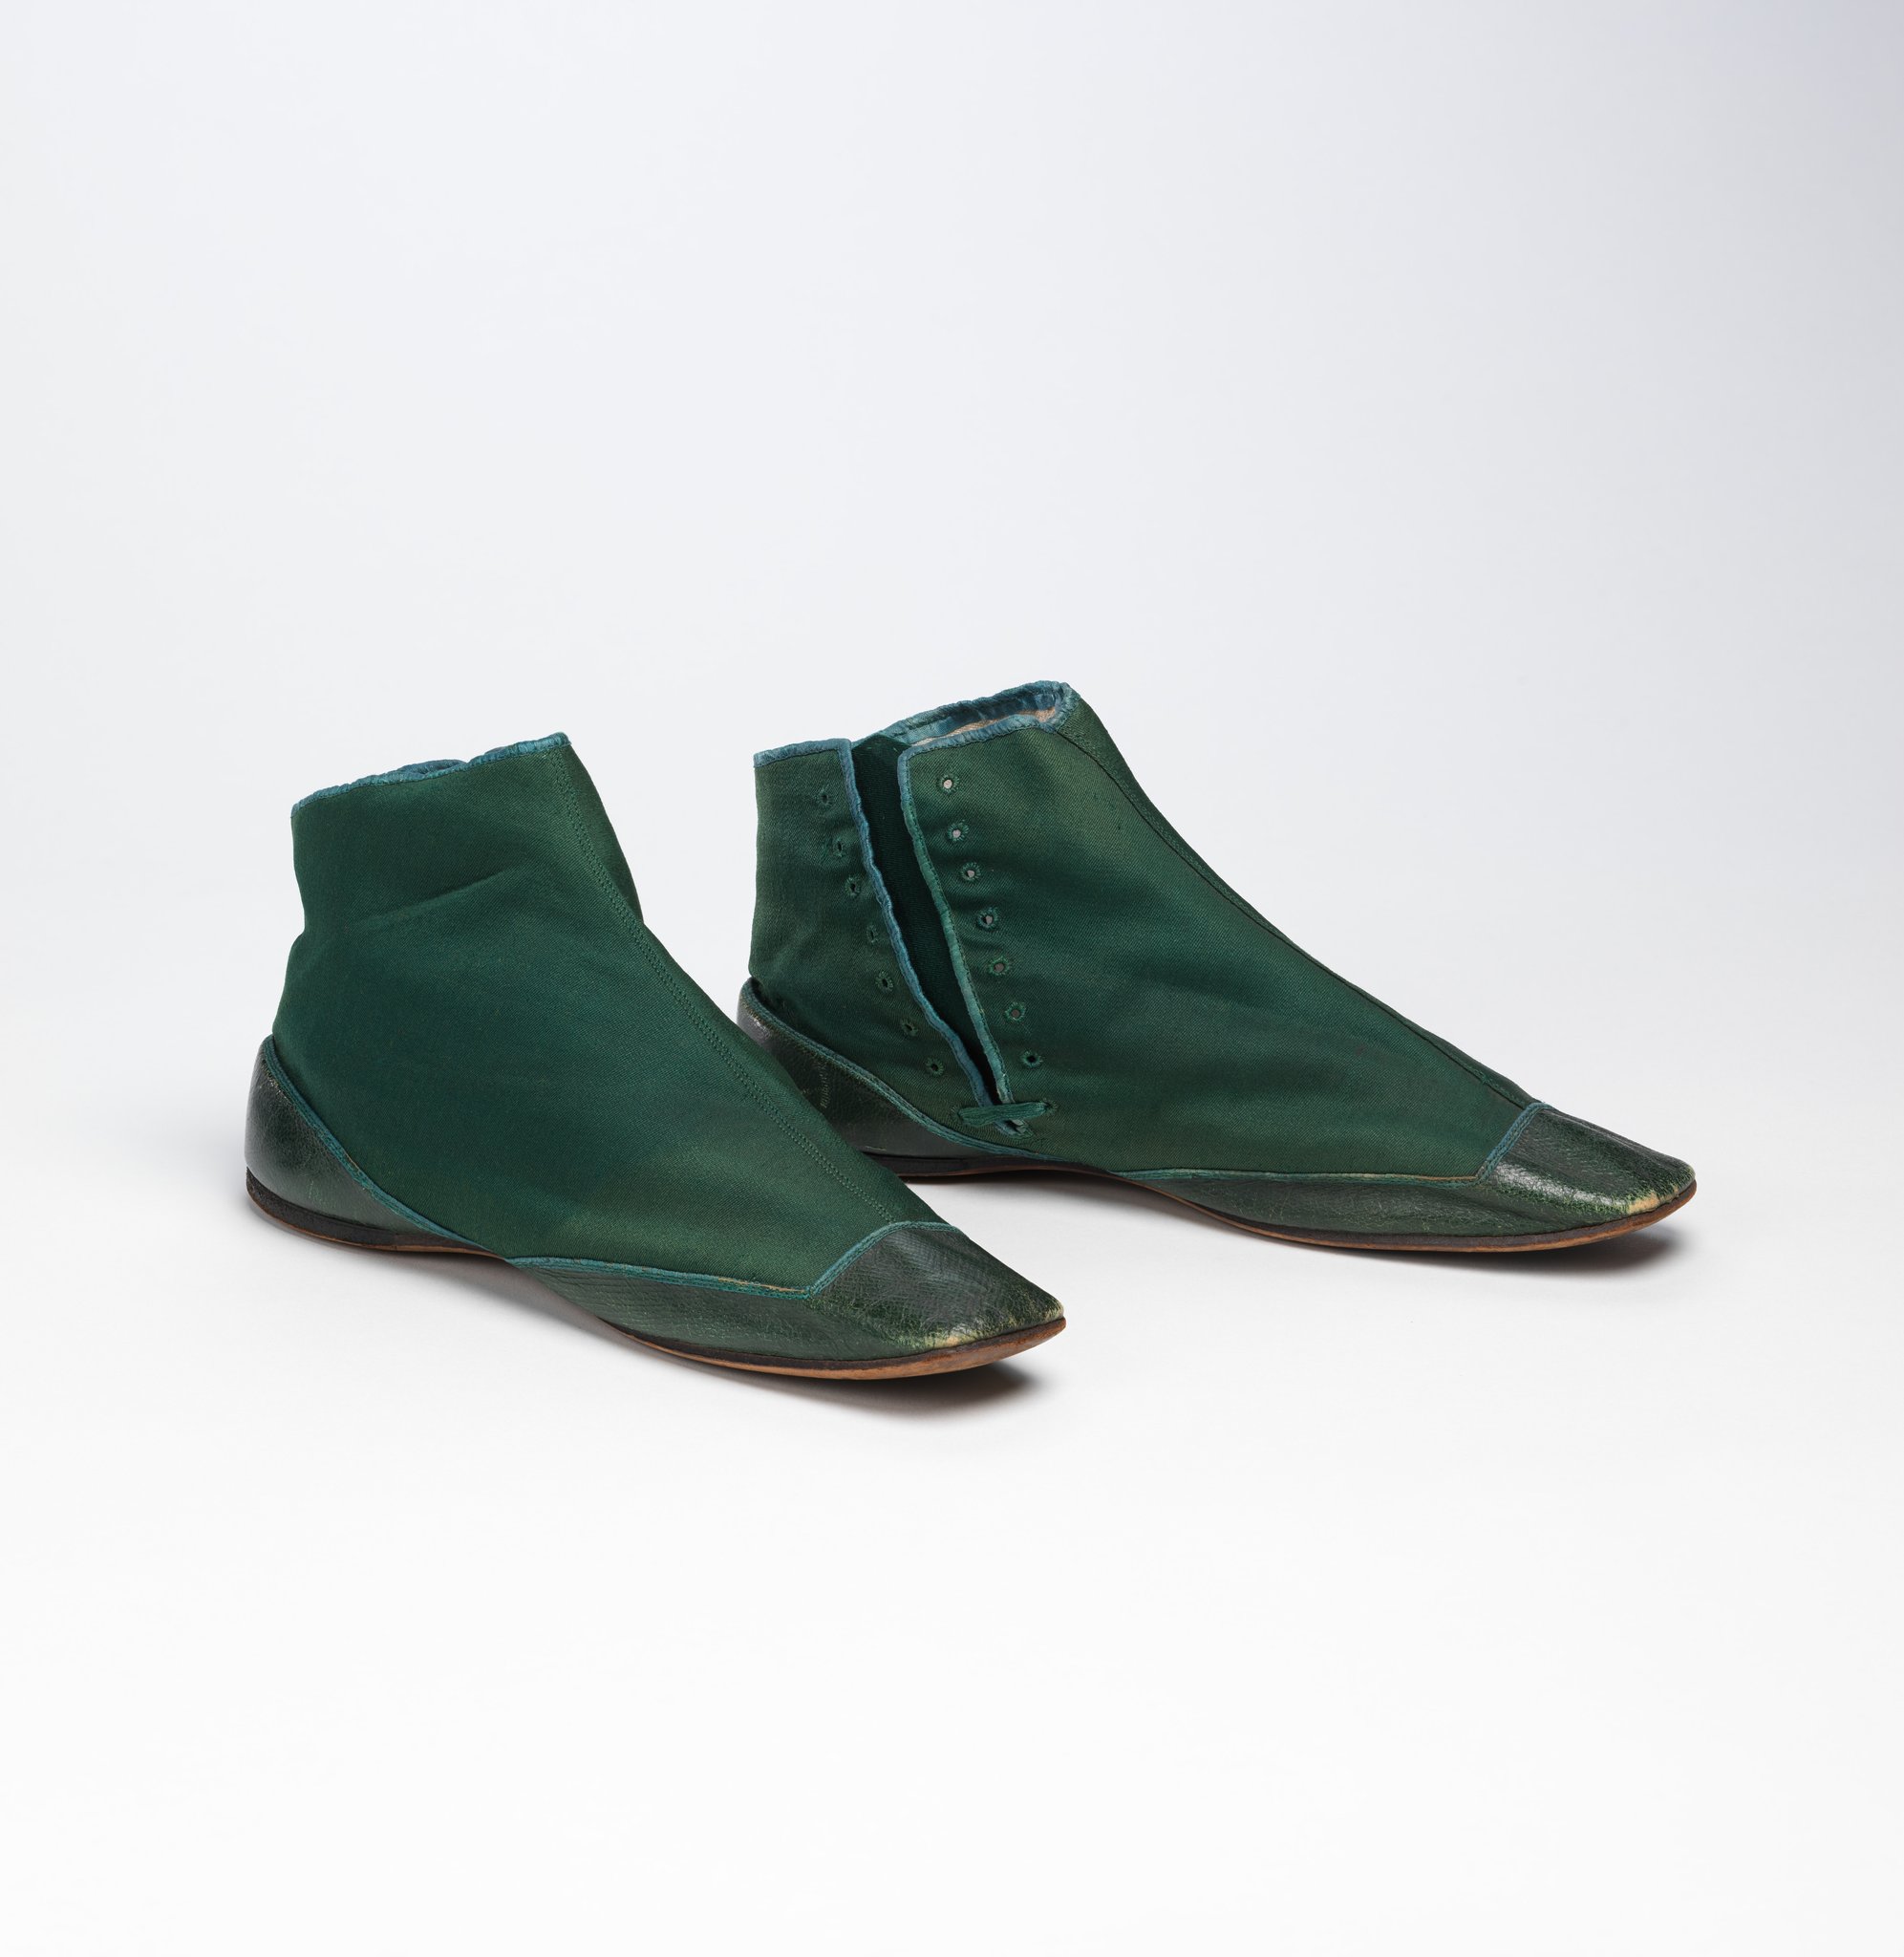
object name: boot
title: Boots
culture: french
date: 1835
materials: cotton, leather